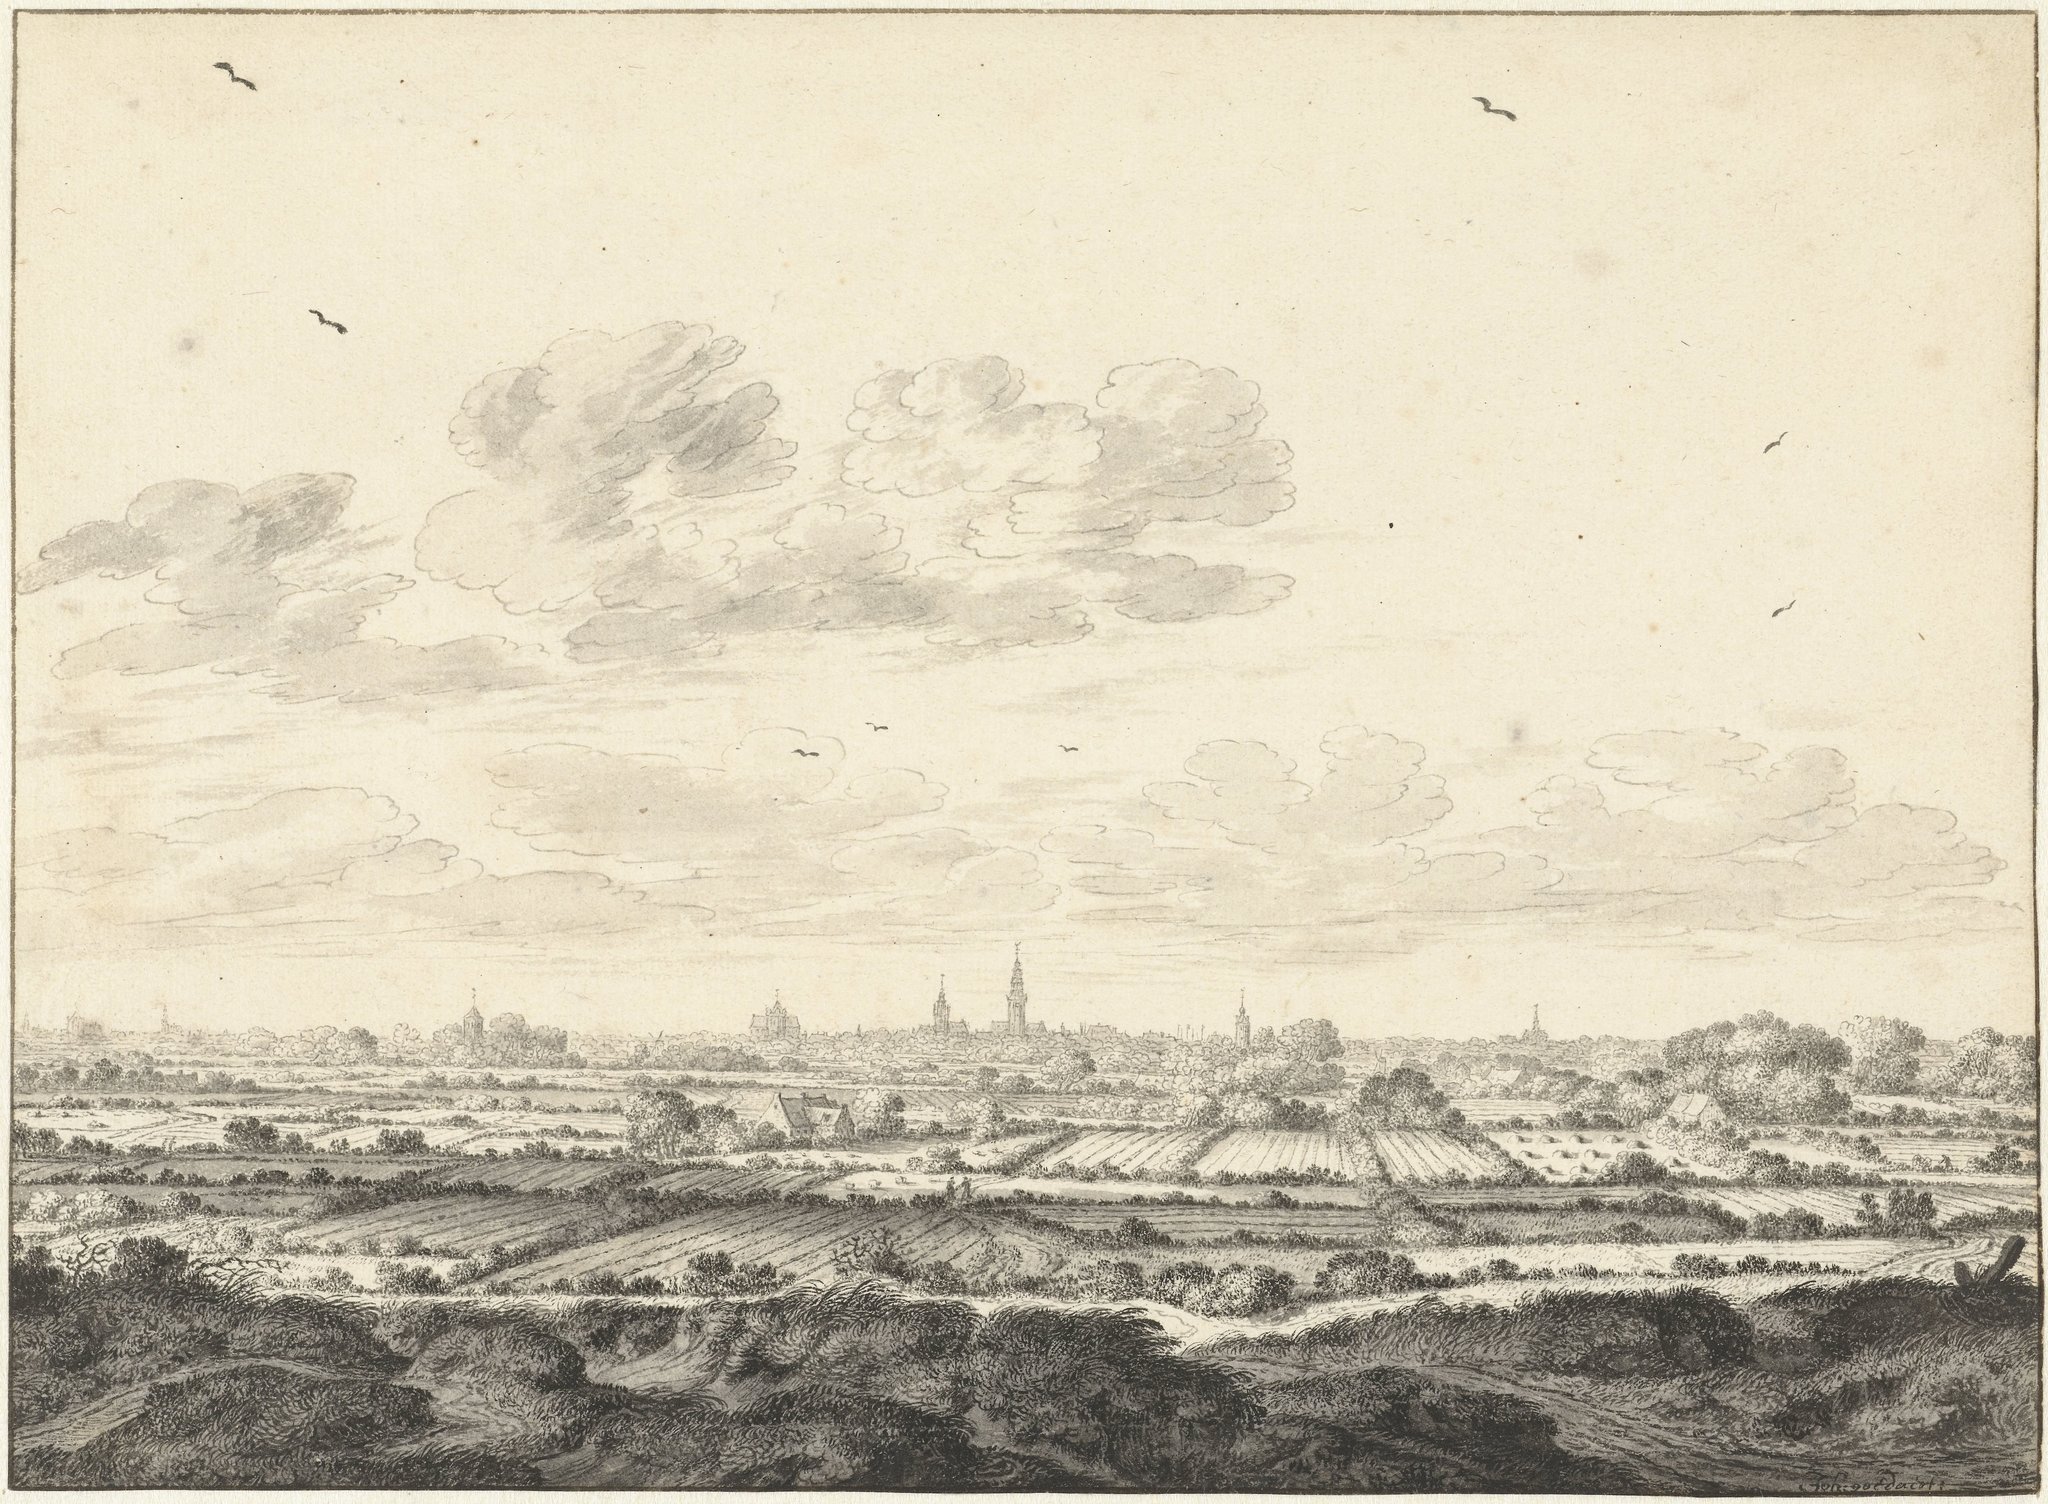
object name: drawing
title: Gezicht op Middelburg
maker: johannes goedaert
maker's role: draughtsman, print maker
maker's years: 1620-1668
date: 1630-1668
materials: chalk, ink, paper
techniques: brush, pen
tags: prospect of city, town panorama, silhouette of city, middelburg